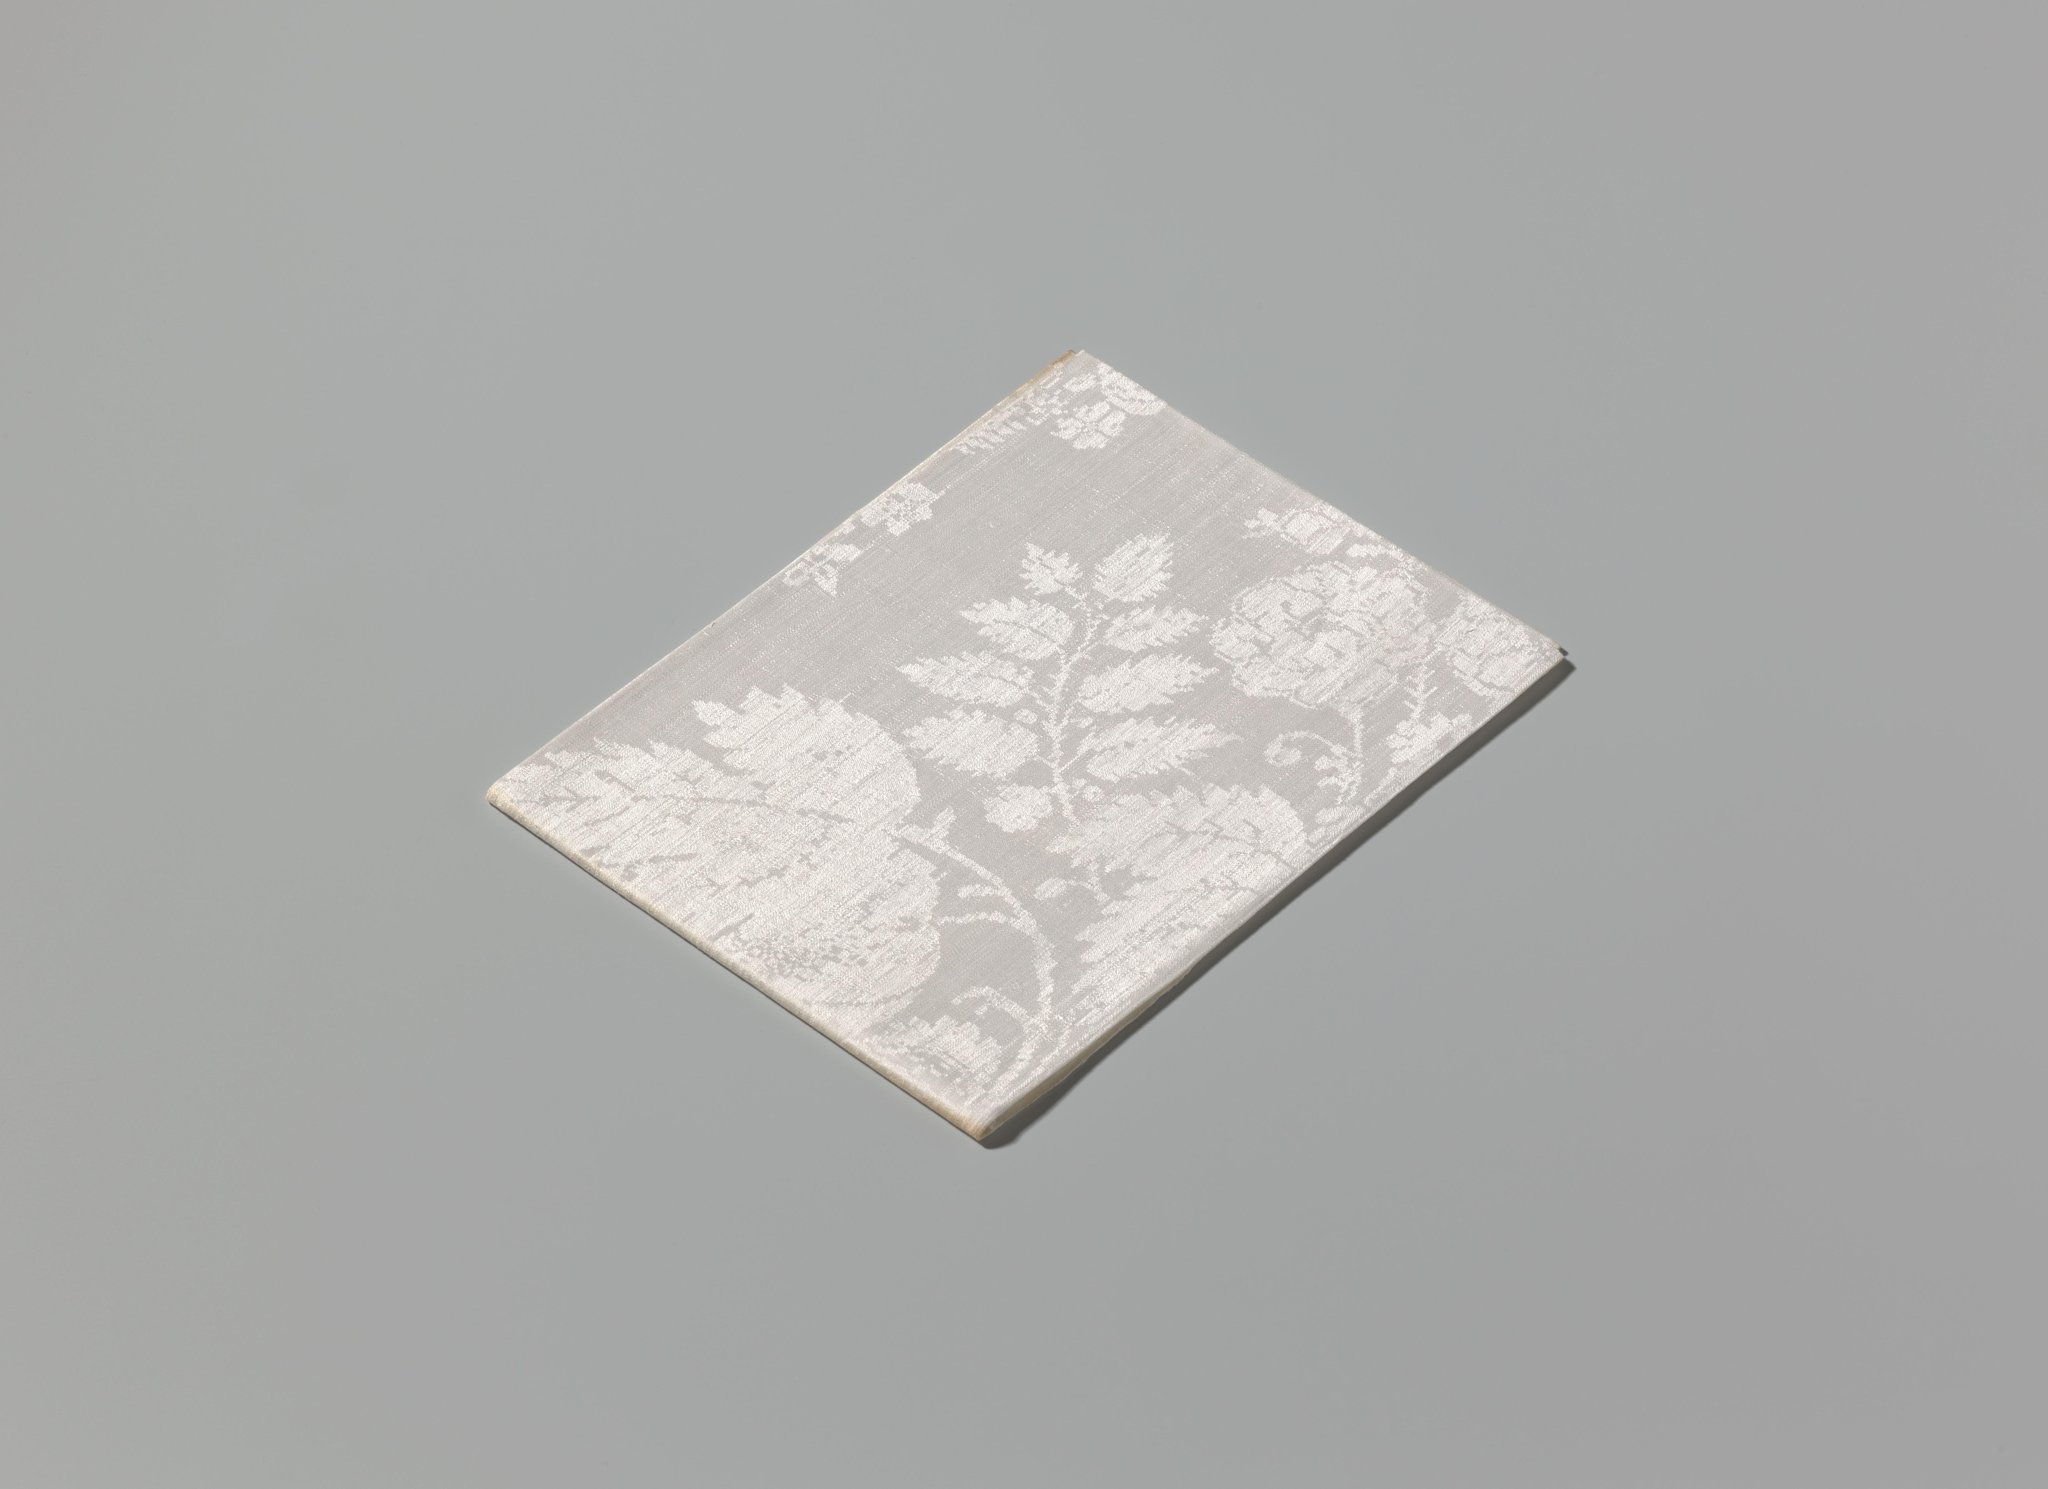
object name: napkin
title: Servet van linnendamast met een kantpatroon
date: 1725-1730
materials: linen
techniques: damask, weave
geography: northern netherlands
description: Wit linnendamasten servet met z.g. kantpatroon, merk kroon IAVG 16.